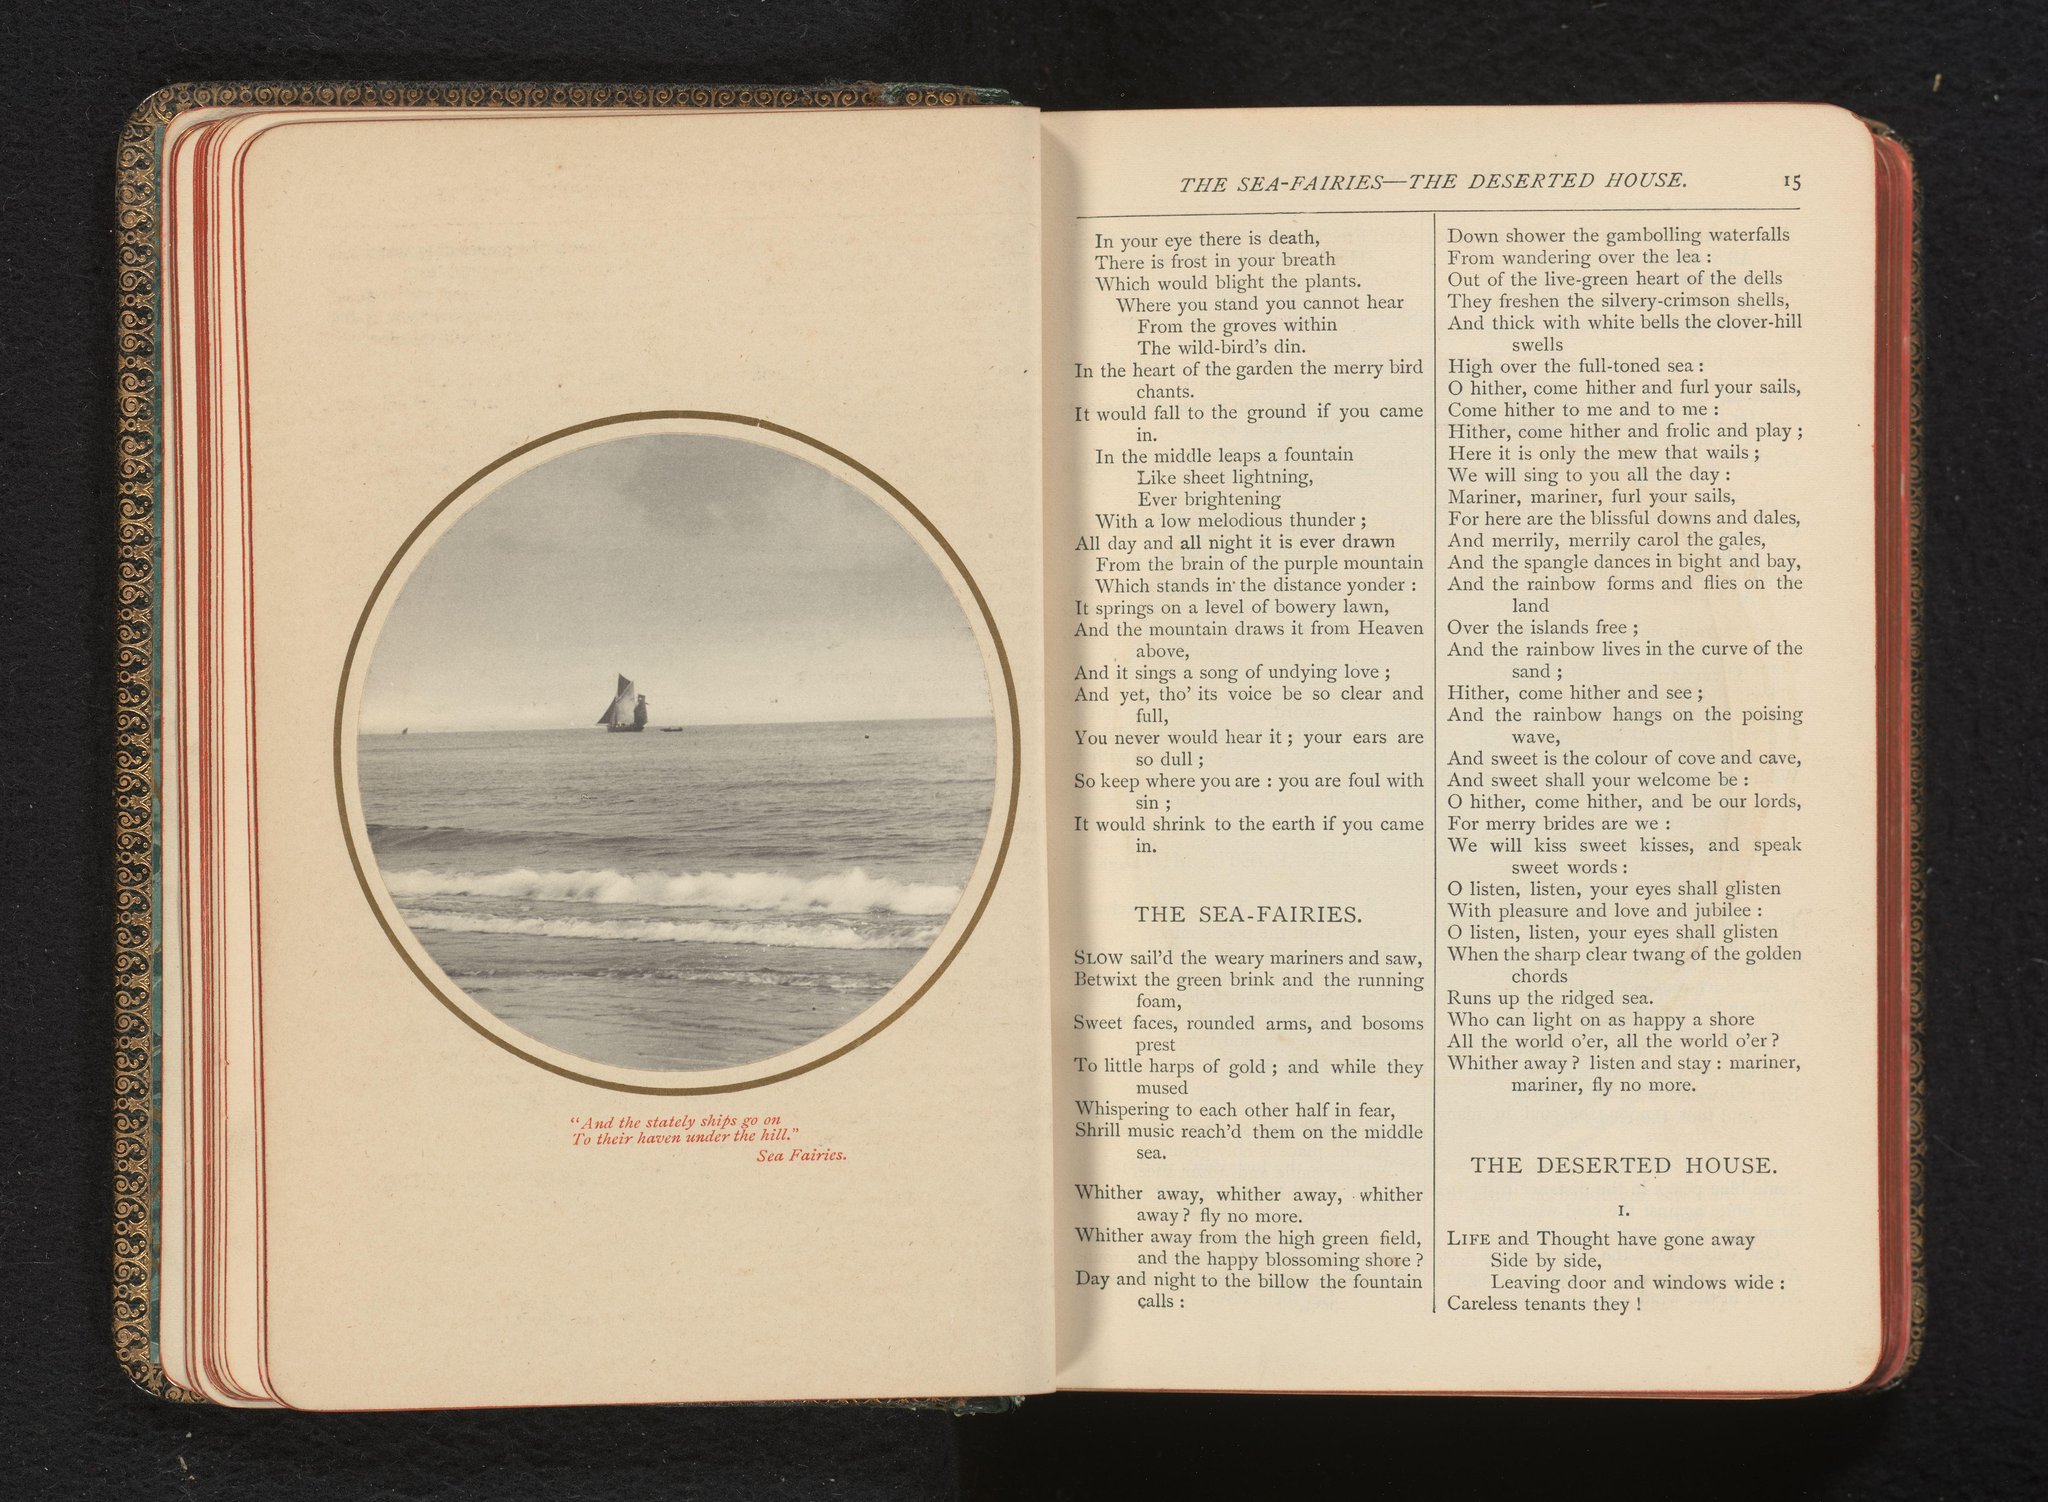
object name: page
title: "And the stately ships go on, To their haven under the hill." Sea Fairies.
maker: john payne jennings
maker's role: fotograaf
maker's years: 1843-1926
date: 1895-1900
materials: paper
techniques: platinum process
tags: sailing-ship, sailing-boat, sea (seascape)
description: Foto op ongenummerde pagina tegenover pagina 15.